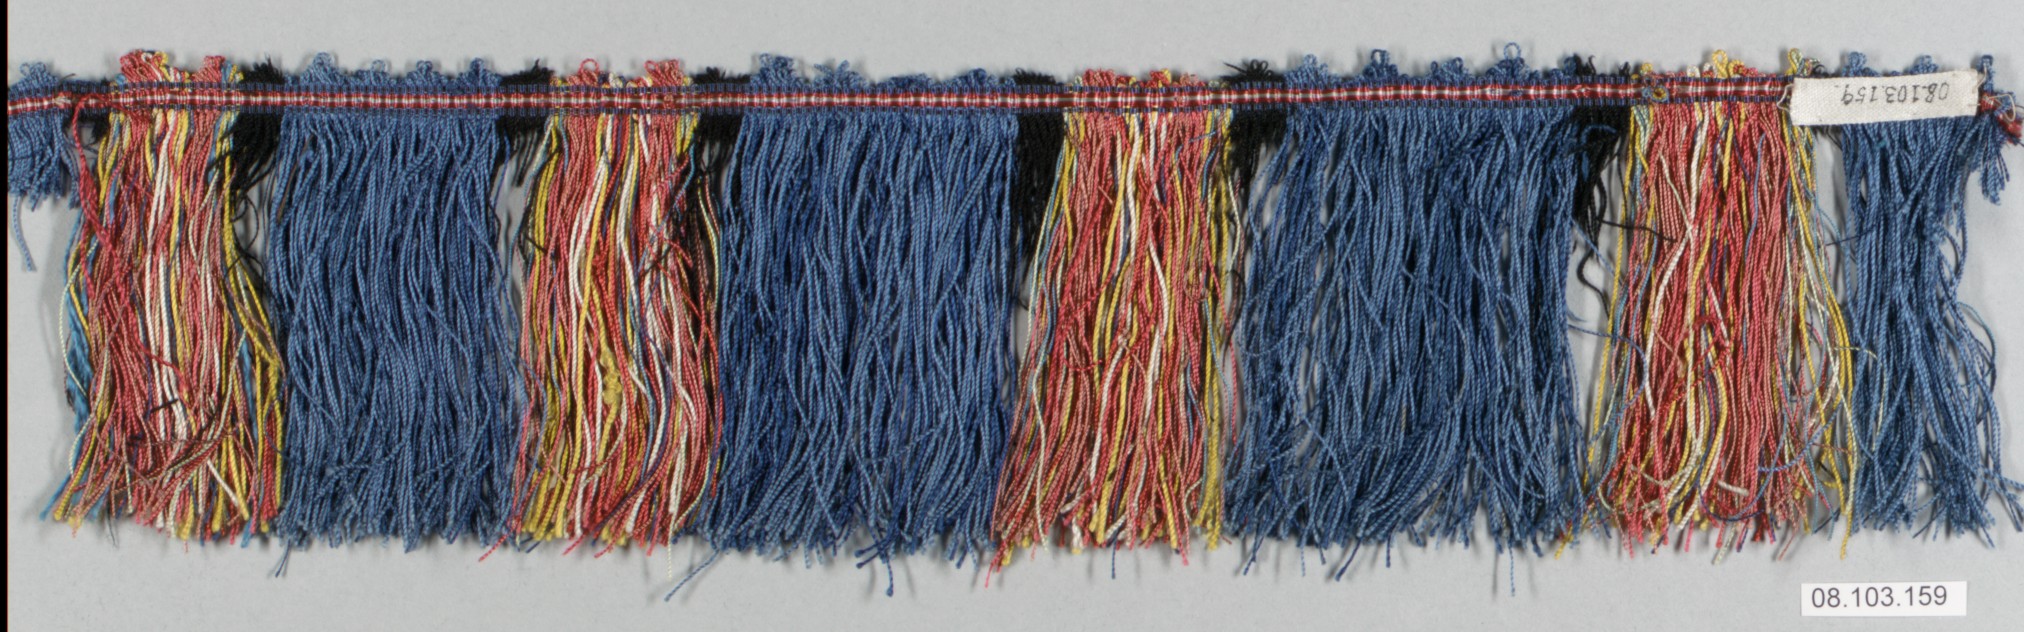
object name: fringe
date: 1801-1900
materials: silk